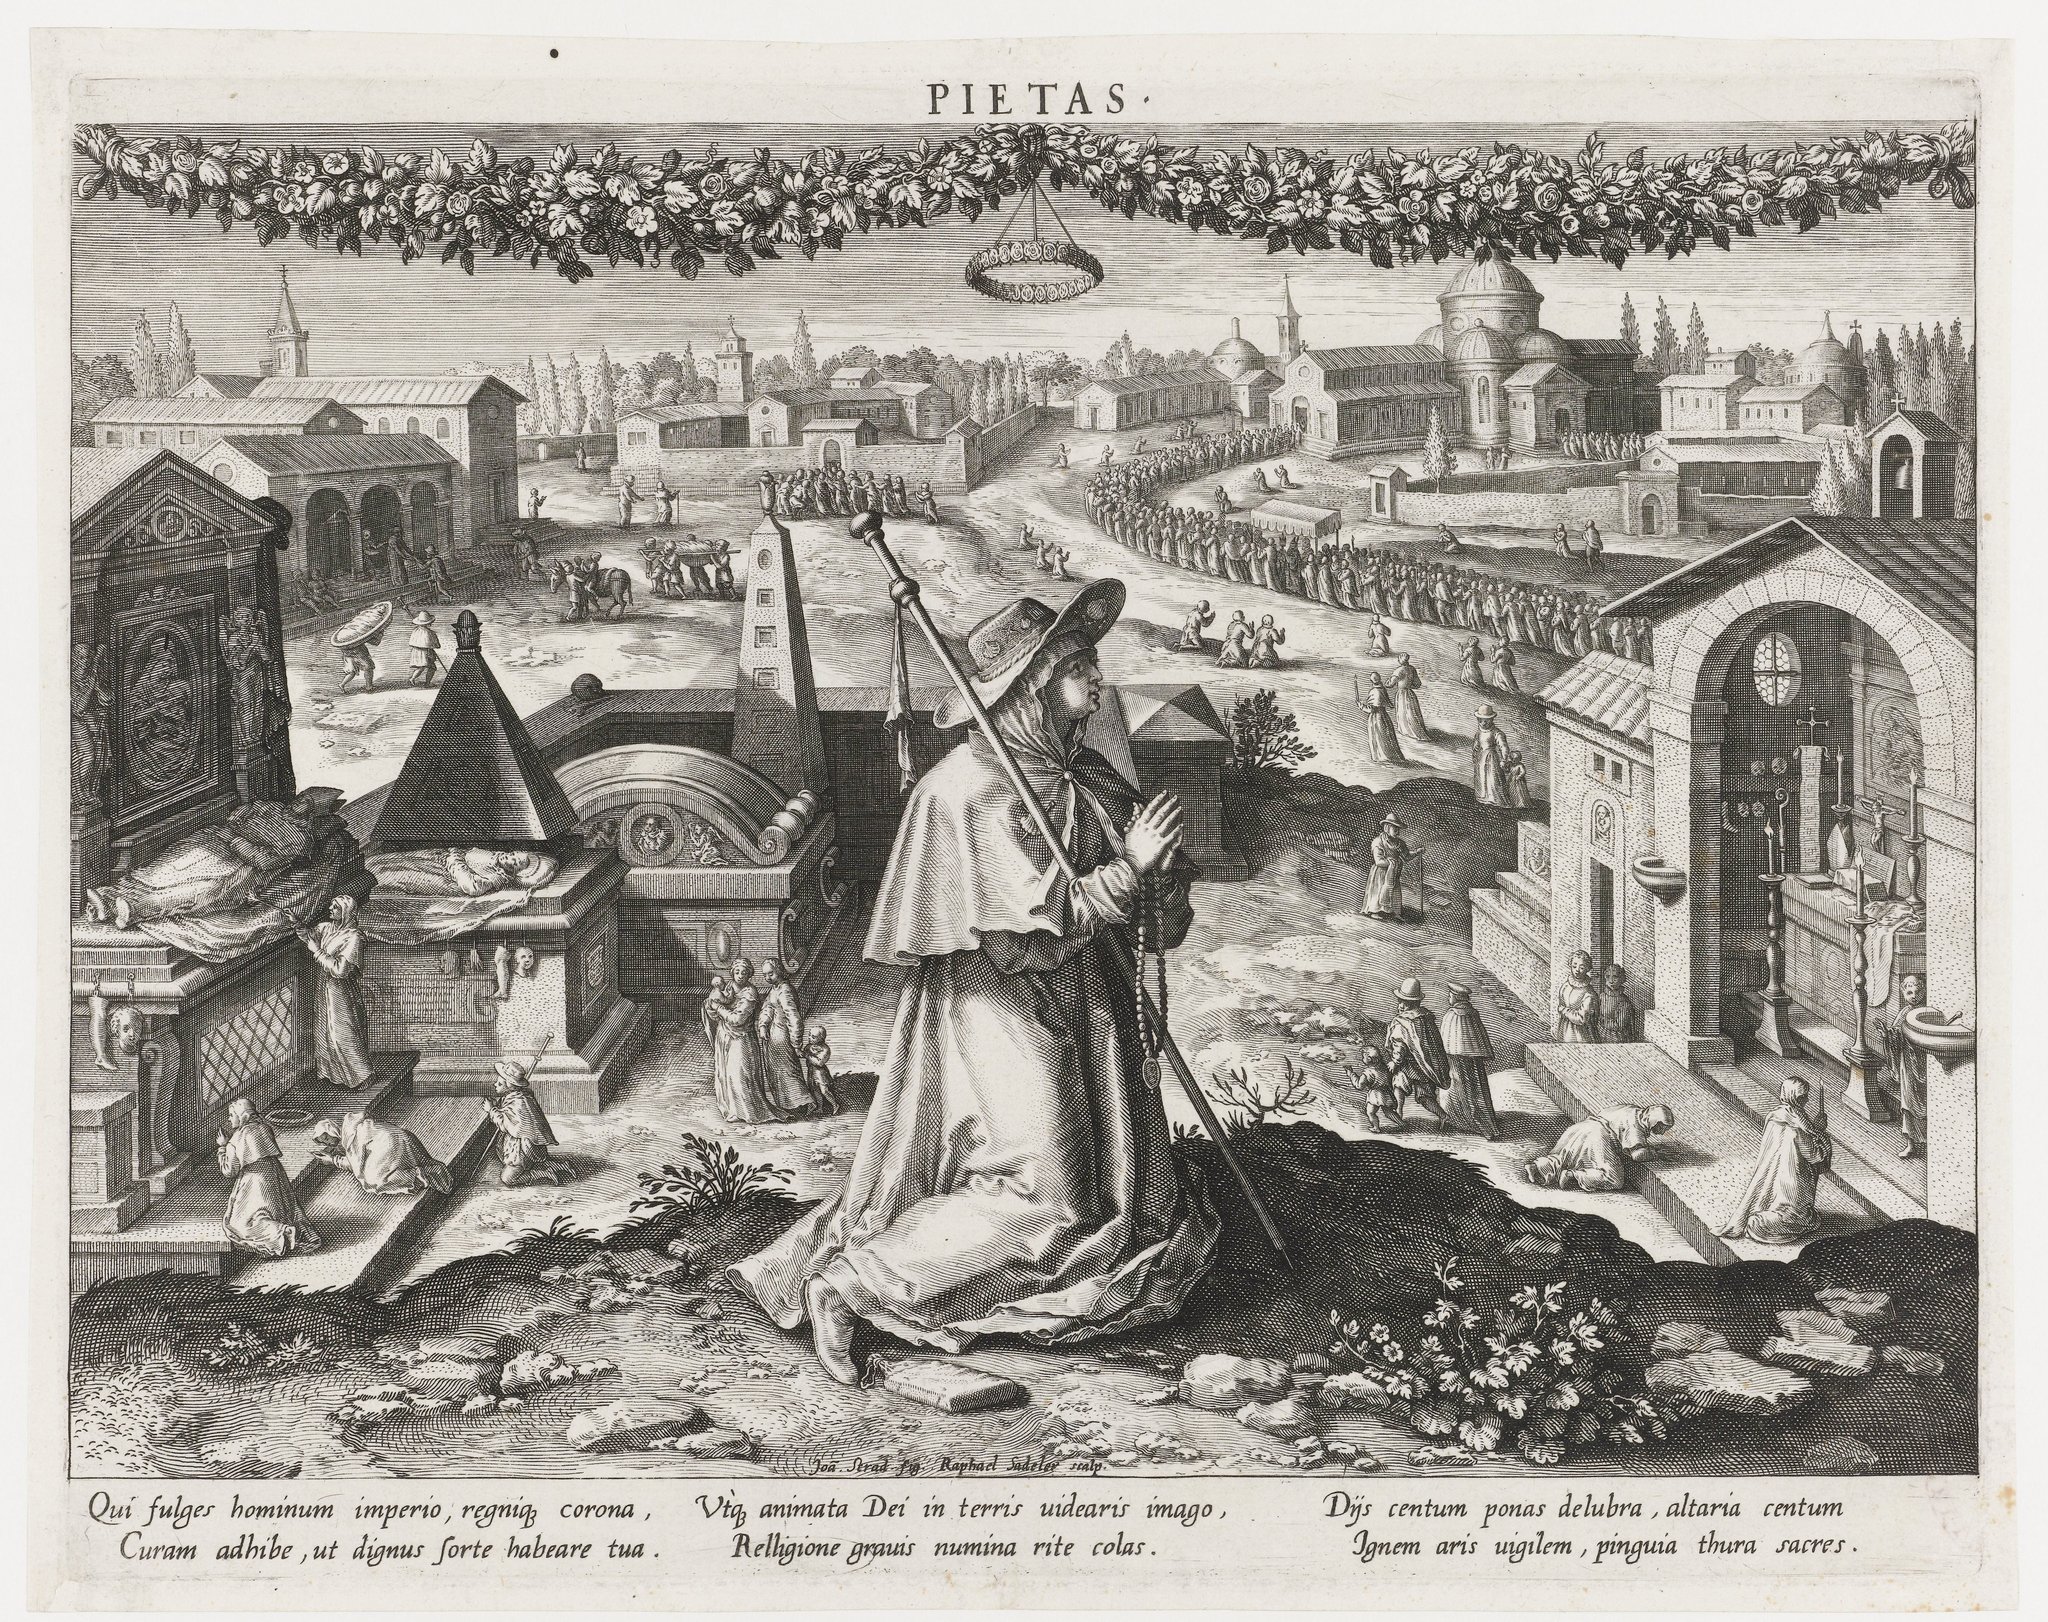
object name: print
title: Belangrijkste bezigheden van een prins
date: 1597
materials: paper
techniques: engraving, etching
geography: venice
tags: burial, sham-grave, cenotaph, 'pietas'; 'pietà' (ripa), hospital, pilgrim's dress and attributes, e.g. flask, hat, mantle, staff, altar with altar-piece, public worship and liturgy of the christian churches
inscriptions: collector's mark: Lugt 240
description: De personificatie van de vroomheid. Hij zit geknield de rozenkrans te bidden en draagt een pelgrimsgewaad. Links de aanbidding van het graf van een bisschop. Rechts de aanbidding van een altaar. Op de achtergrond links een ziekenhuis, rechts een begrafenisprocessie. De prent heeft een Latijns onderschrift met uitleg over het belang van een vroom geloof voor een vorst. De vijfde prent van een vijfdelige serie met als onderwerp de belangrijkste bezigheden van een prins.